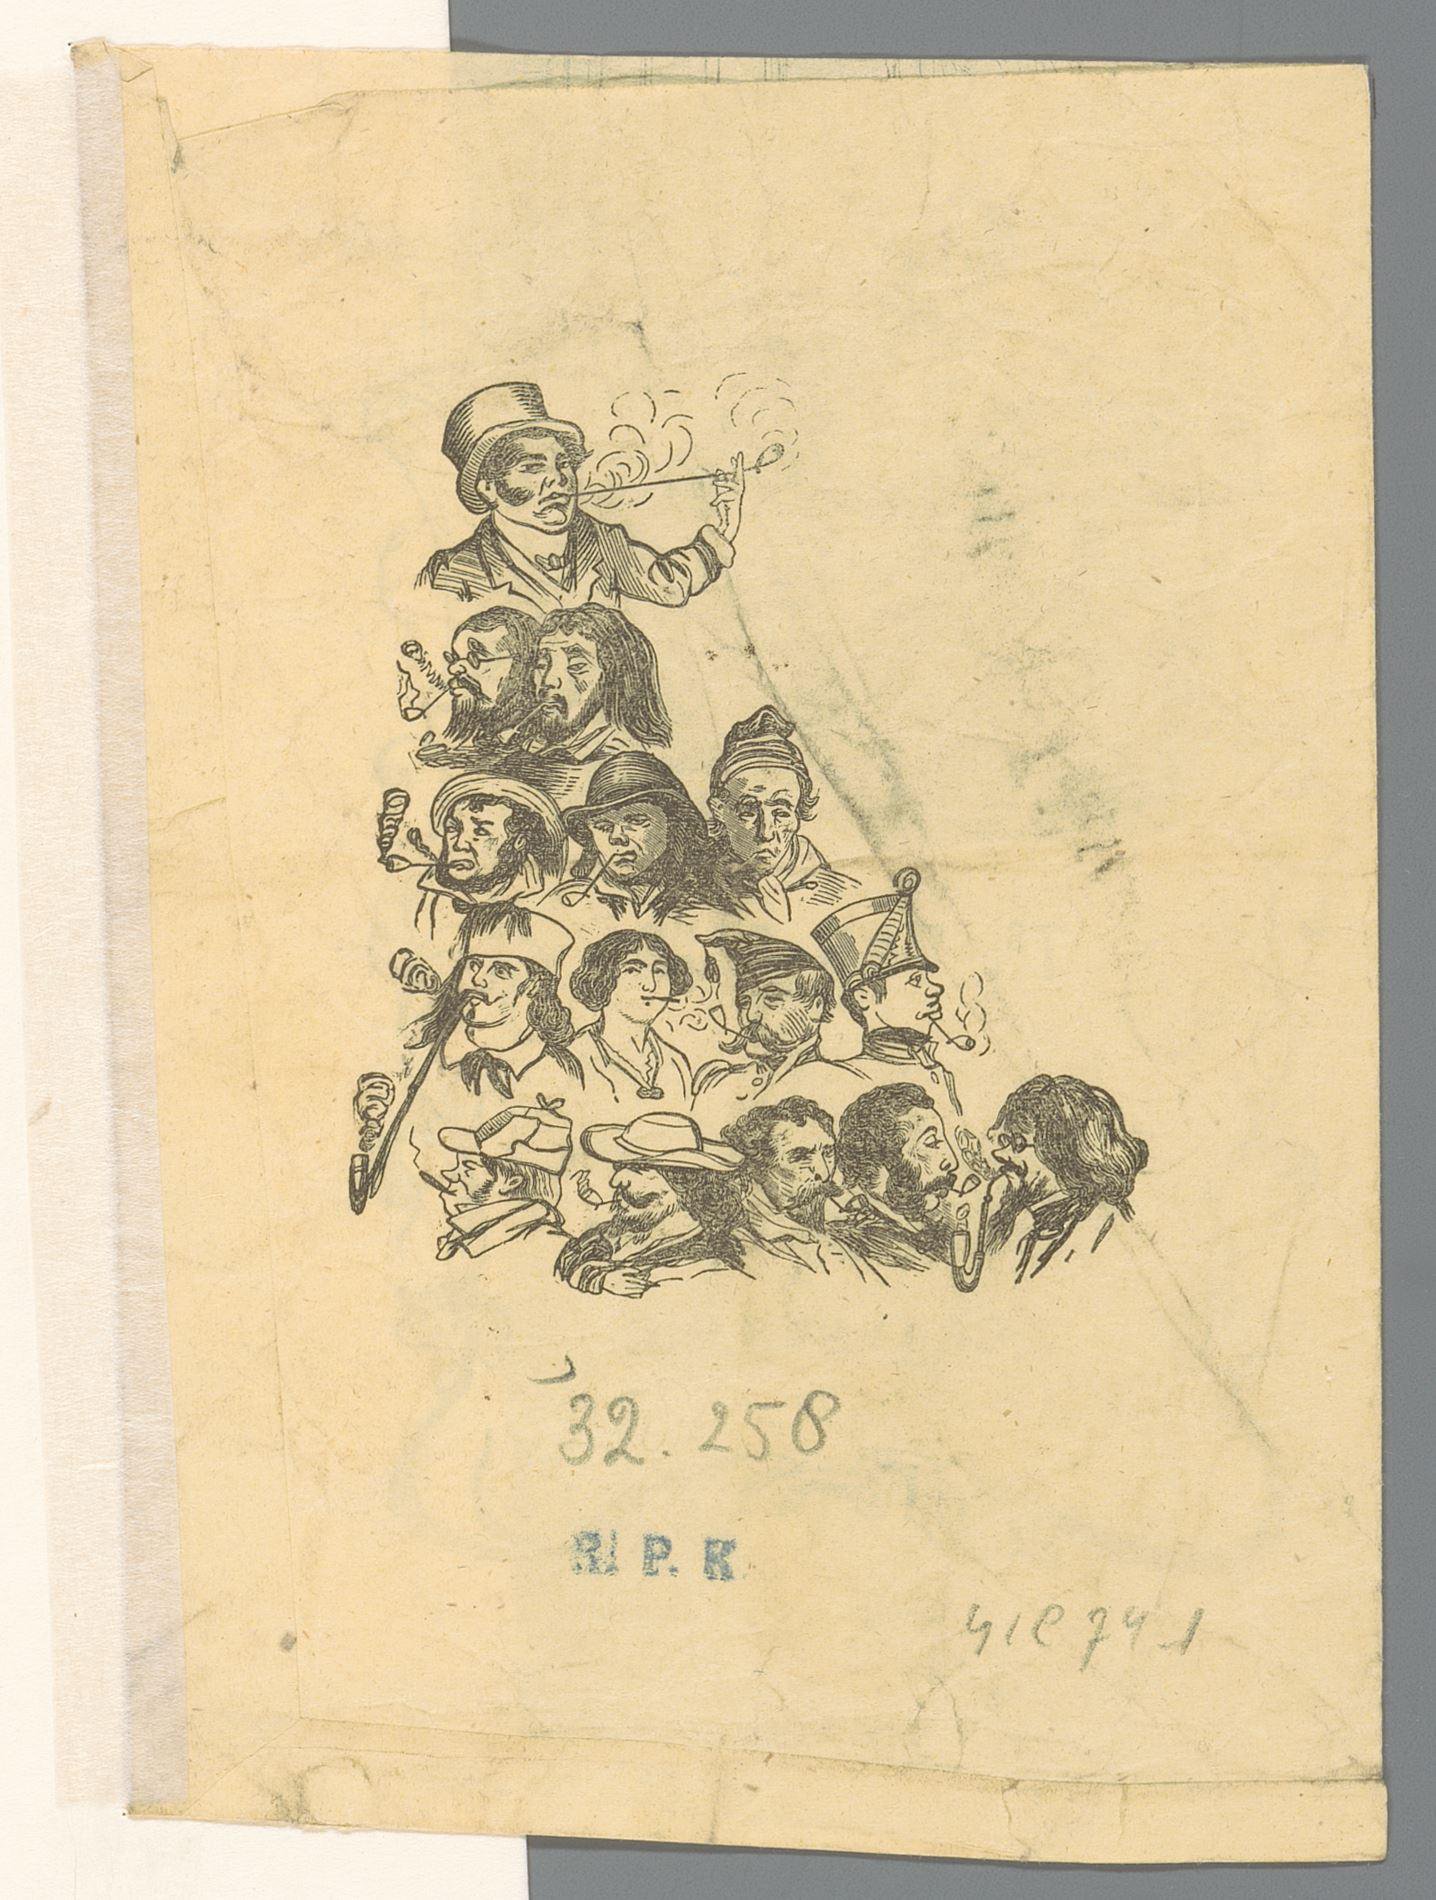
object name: print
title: Verschillende rokende figuren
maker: Anonymous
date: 1830-1899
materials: paper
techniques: lithograph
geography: netherlands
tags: pipe ~ tobacco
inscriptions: collector's mark: Lugt 2233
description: Waarschijnlijk betreft dit reclame voor de tabakszaak van Ts. van Dijk in de Hofstraat, nr. 134, te den Haag.